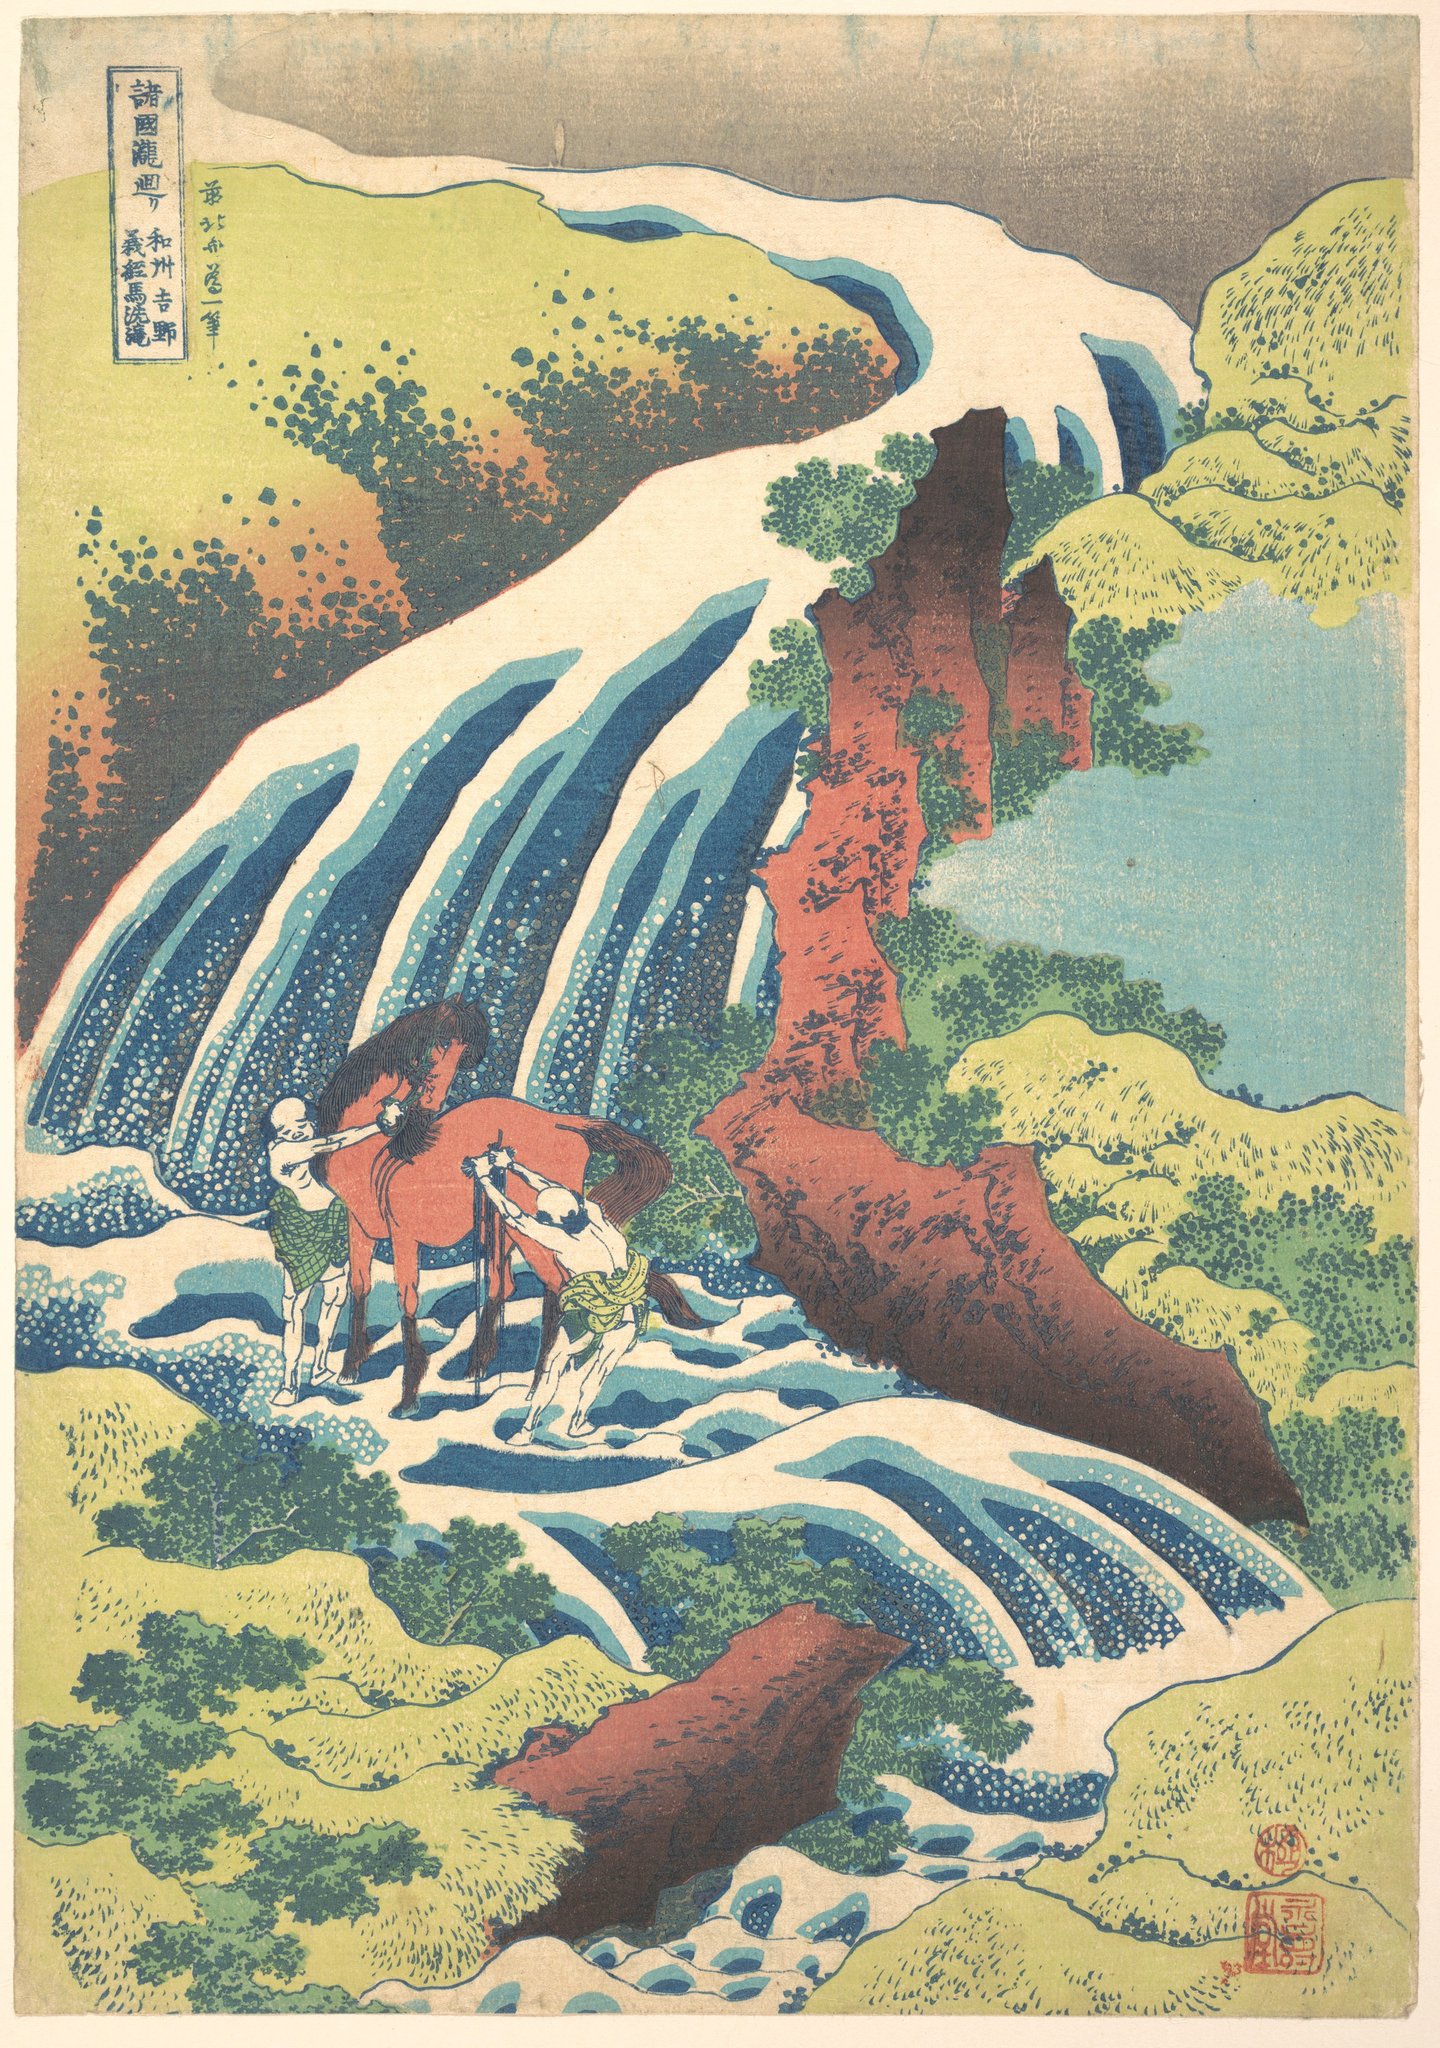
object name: woodblock print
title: “The Waterfall Where Yoshitsune Washed His Horse at Yoshino in Yamato Province,” from the series A Tour of Waterfalls in Various Provinces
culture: japanese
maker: katsushika hokusai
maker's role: artist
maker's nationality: japanese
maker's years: 1760-1849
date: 1832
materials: ink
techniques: woodblock print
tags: men,horses,waterfalls,washing